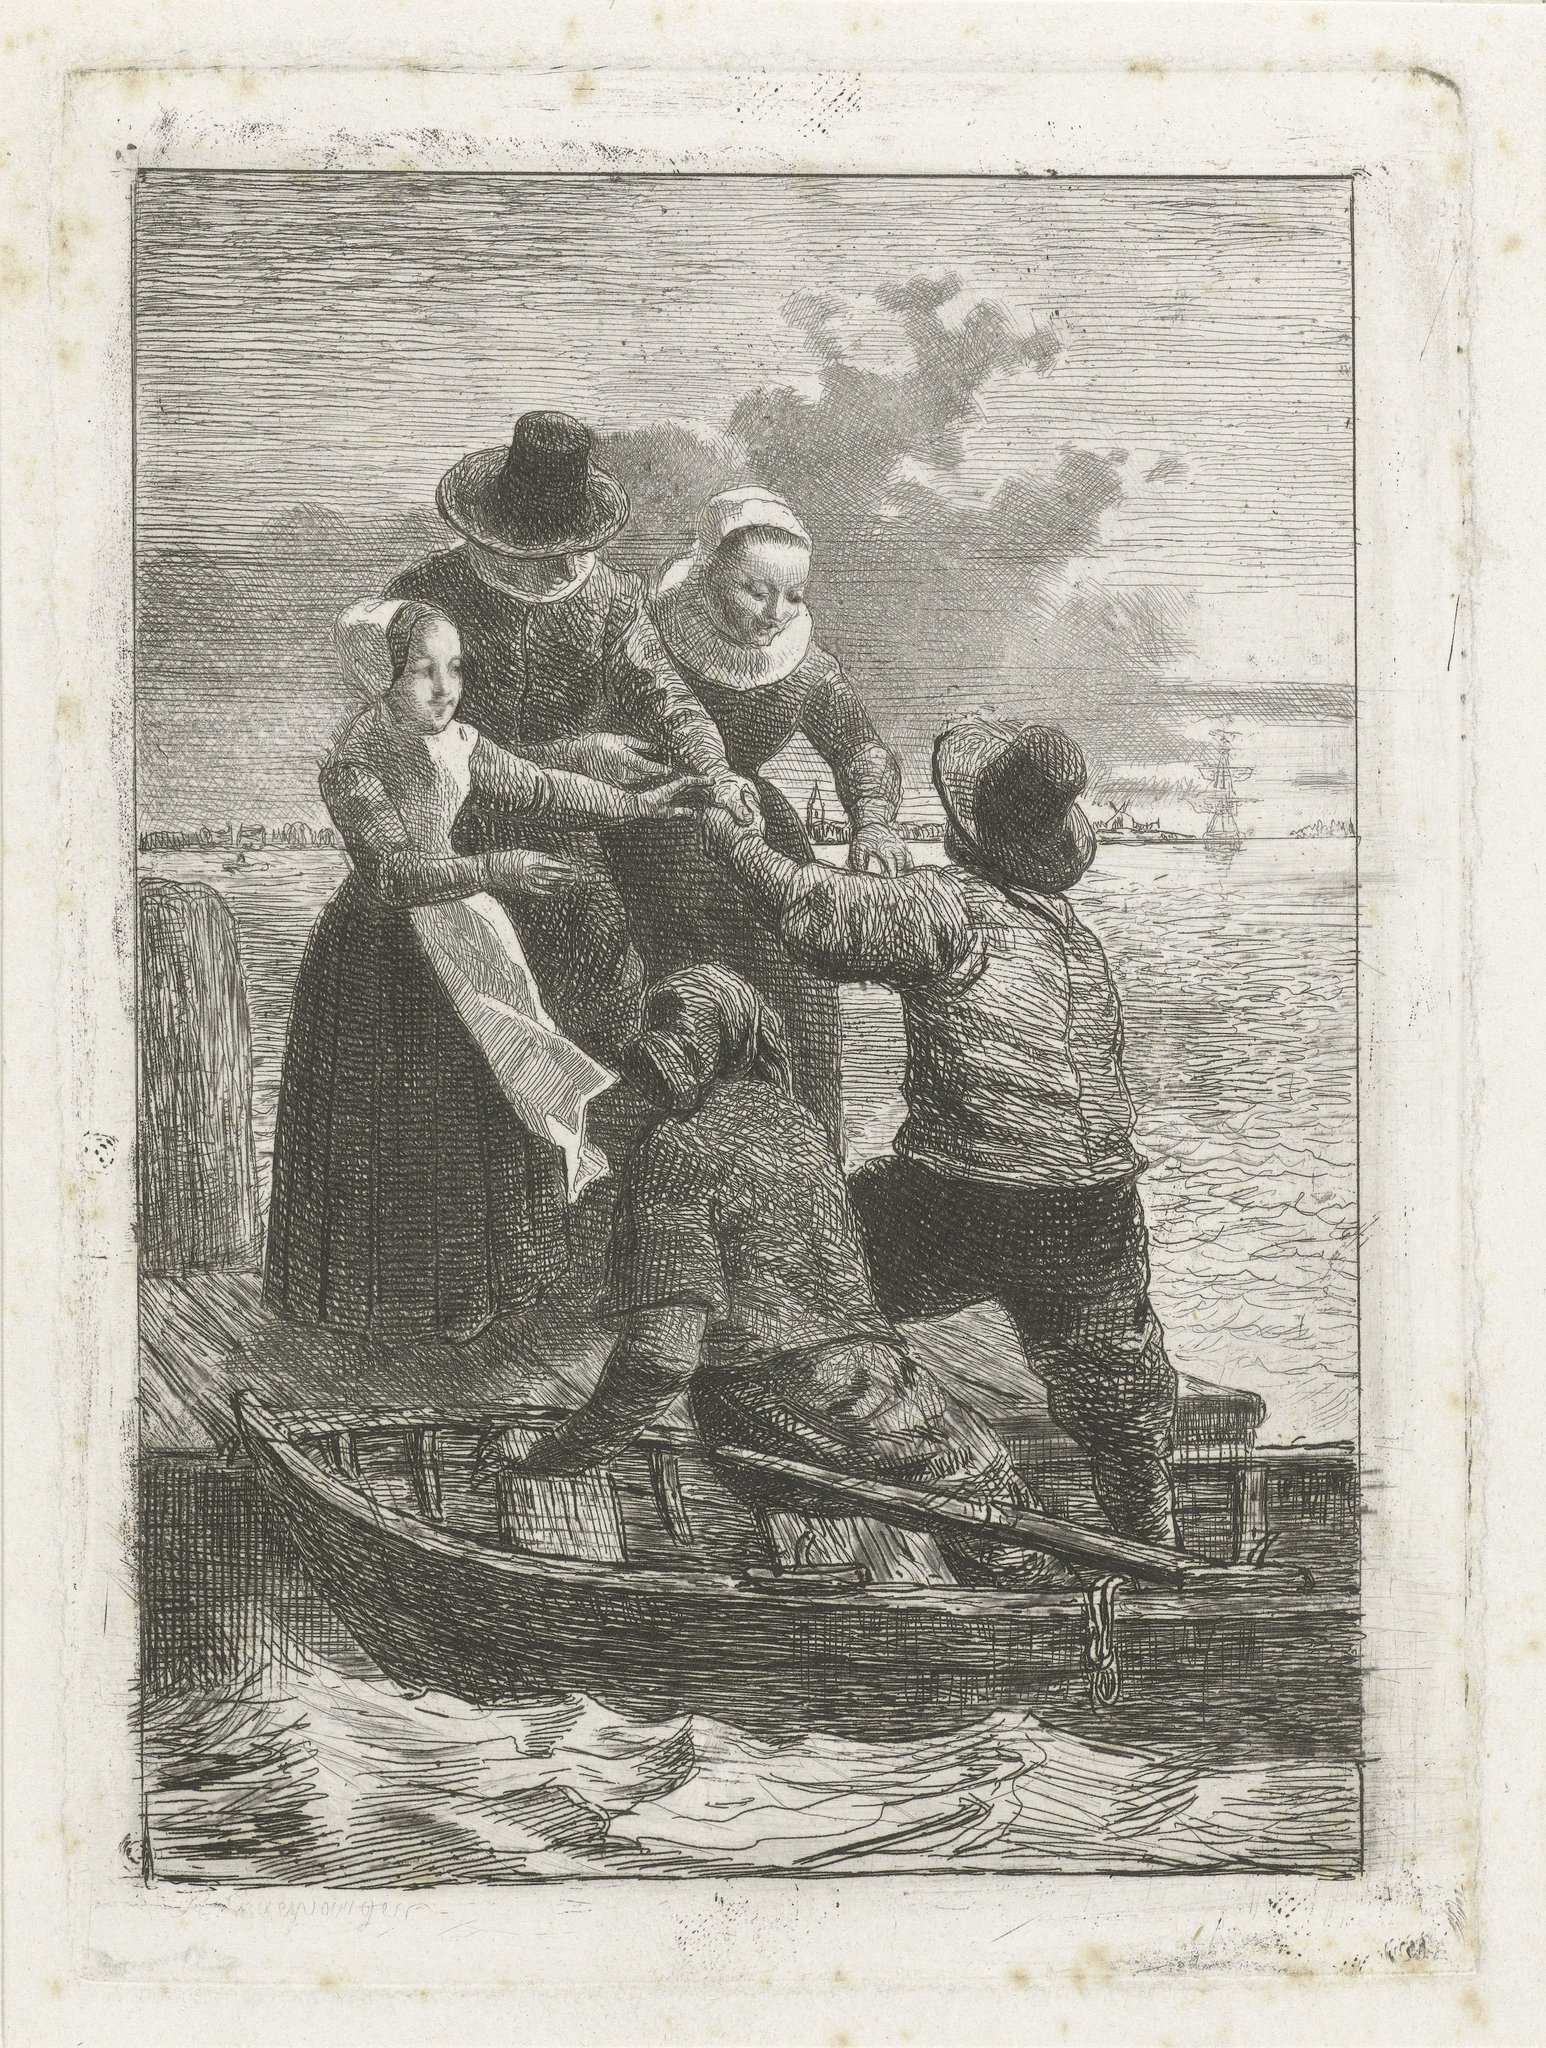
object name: print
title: Inscheping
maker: reinier craeyvanger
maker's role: draughtsman, print maker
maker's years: 1812-1880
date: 1822-1880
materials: paper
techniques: etching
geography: amsterdam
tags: family group, especially parents with their child(ren), rowing-boat, canoe, etc., seaman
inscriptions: collector's mark: Lugt 2228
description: Een schipper helpt een gezin van een vader, een moeder en een dochter met inschepen op de roeiboot.